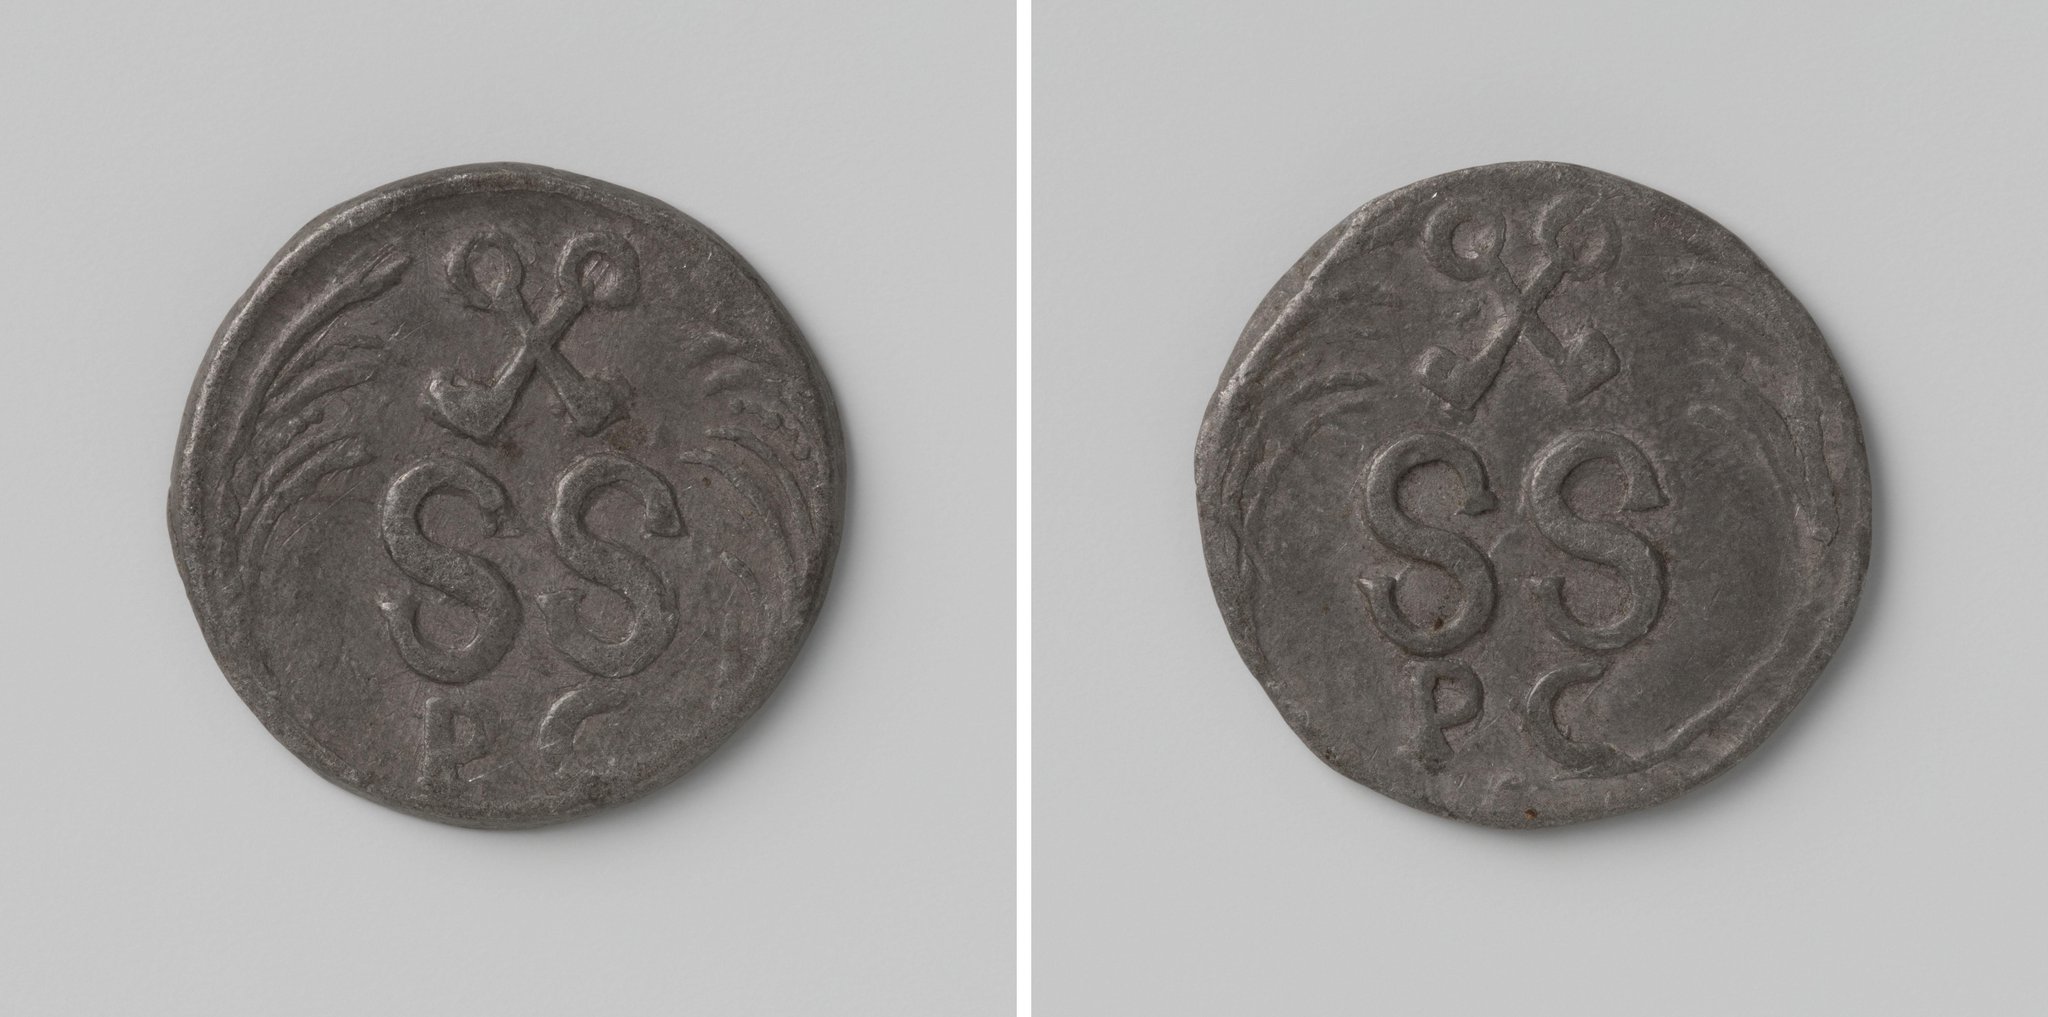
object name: loden penning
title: Kraammoeders te Leiden, loden penning met de opschriften SS en PC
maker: Anonymous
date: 1600-1800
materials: lead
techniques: striking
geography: leiden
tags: leiden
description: Voorzijde: twee gekruiste sleutels onder letters SS en letters PC binnen bladerkrans. Keerzijde: twee gekruiste sleutels onder letters SS en letters PC binnen bladerkrans